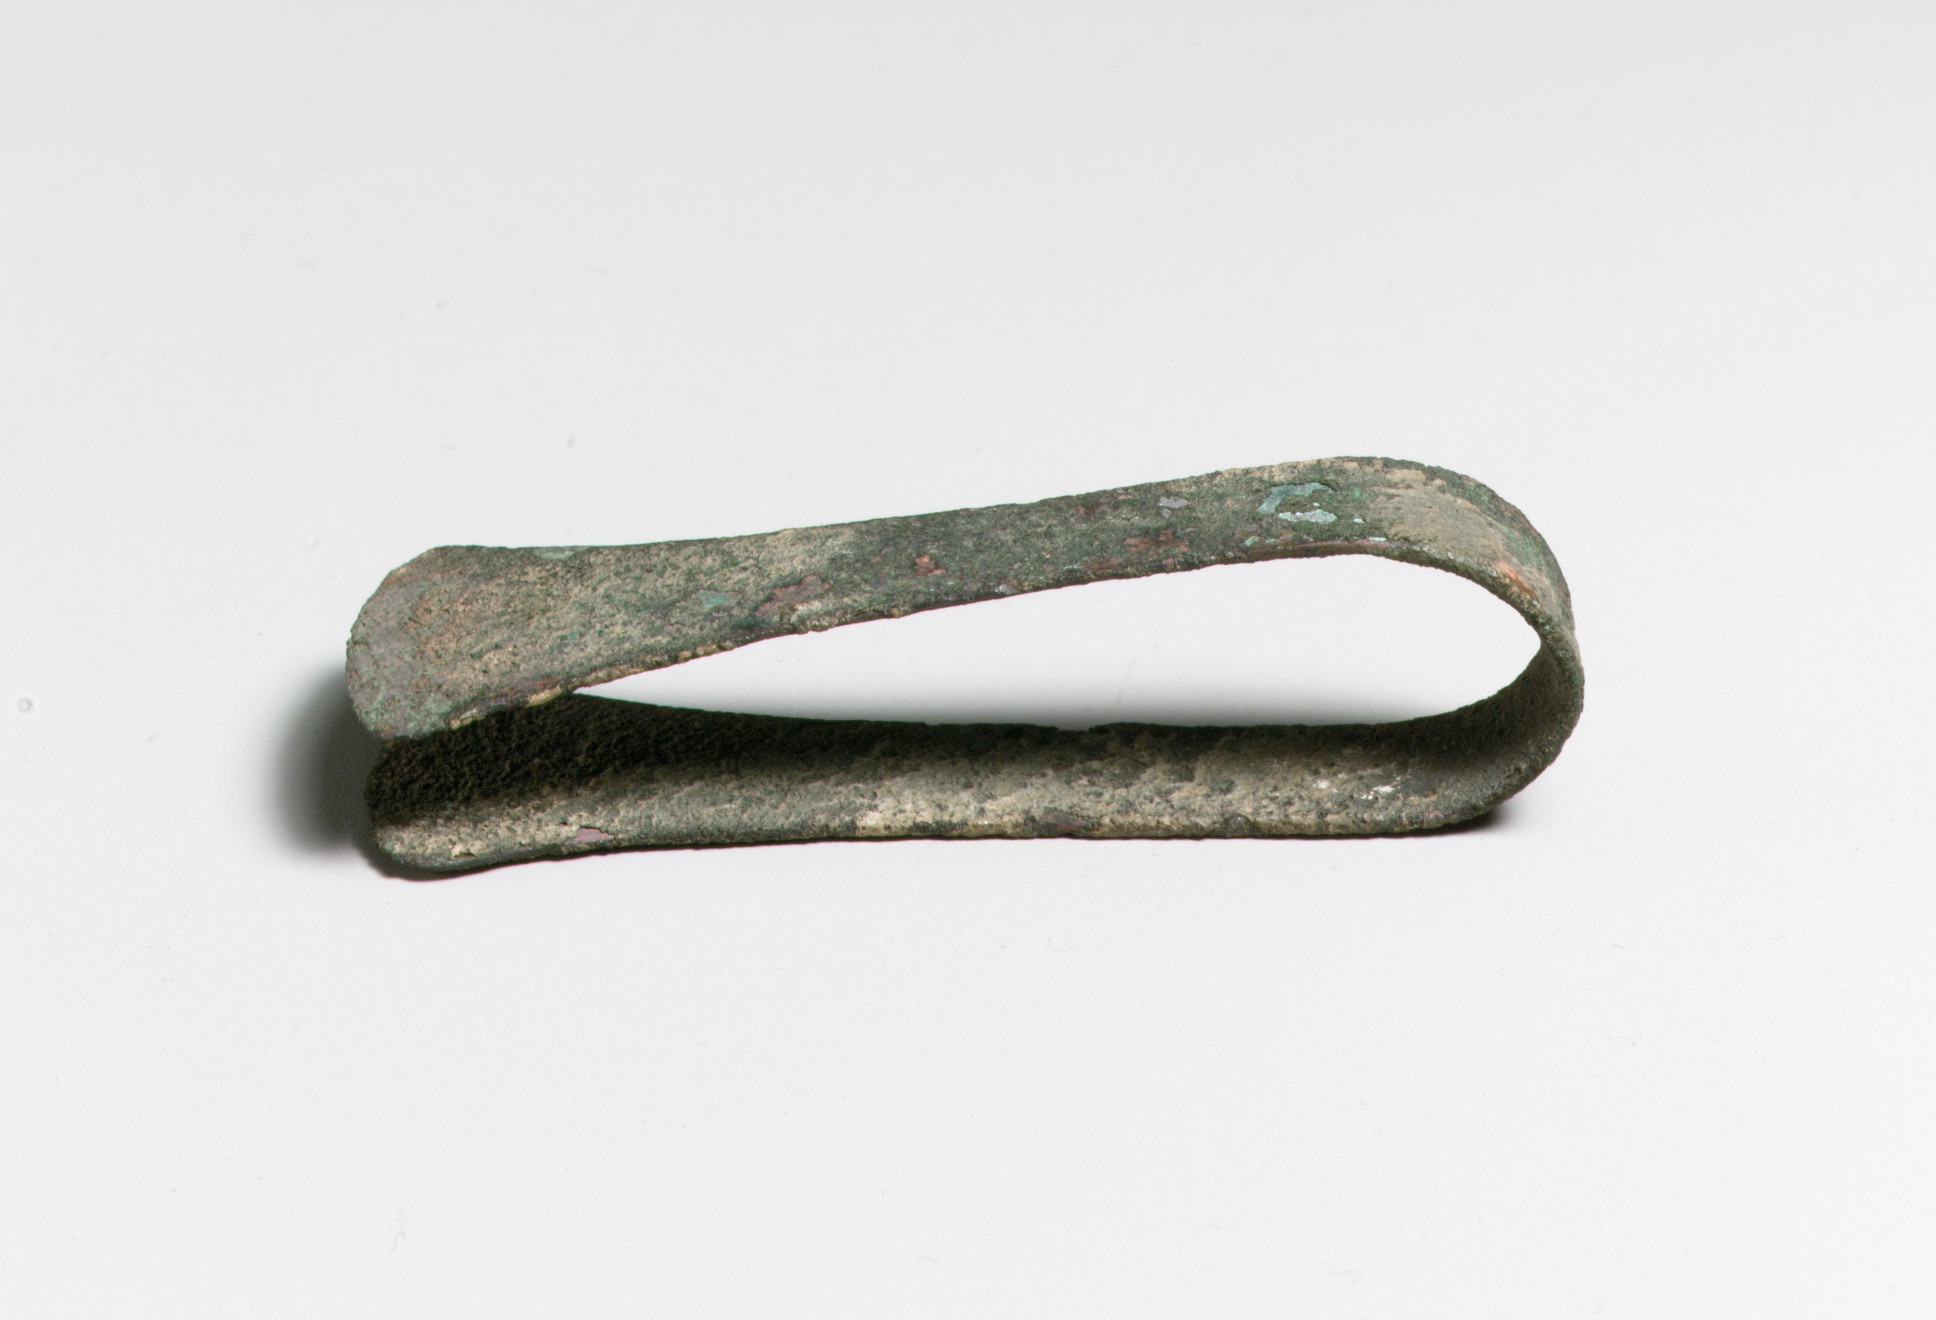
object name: tweezer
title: Tweezers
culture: cypriot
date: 3200-2000 BCE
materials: bronze